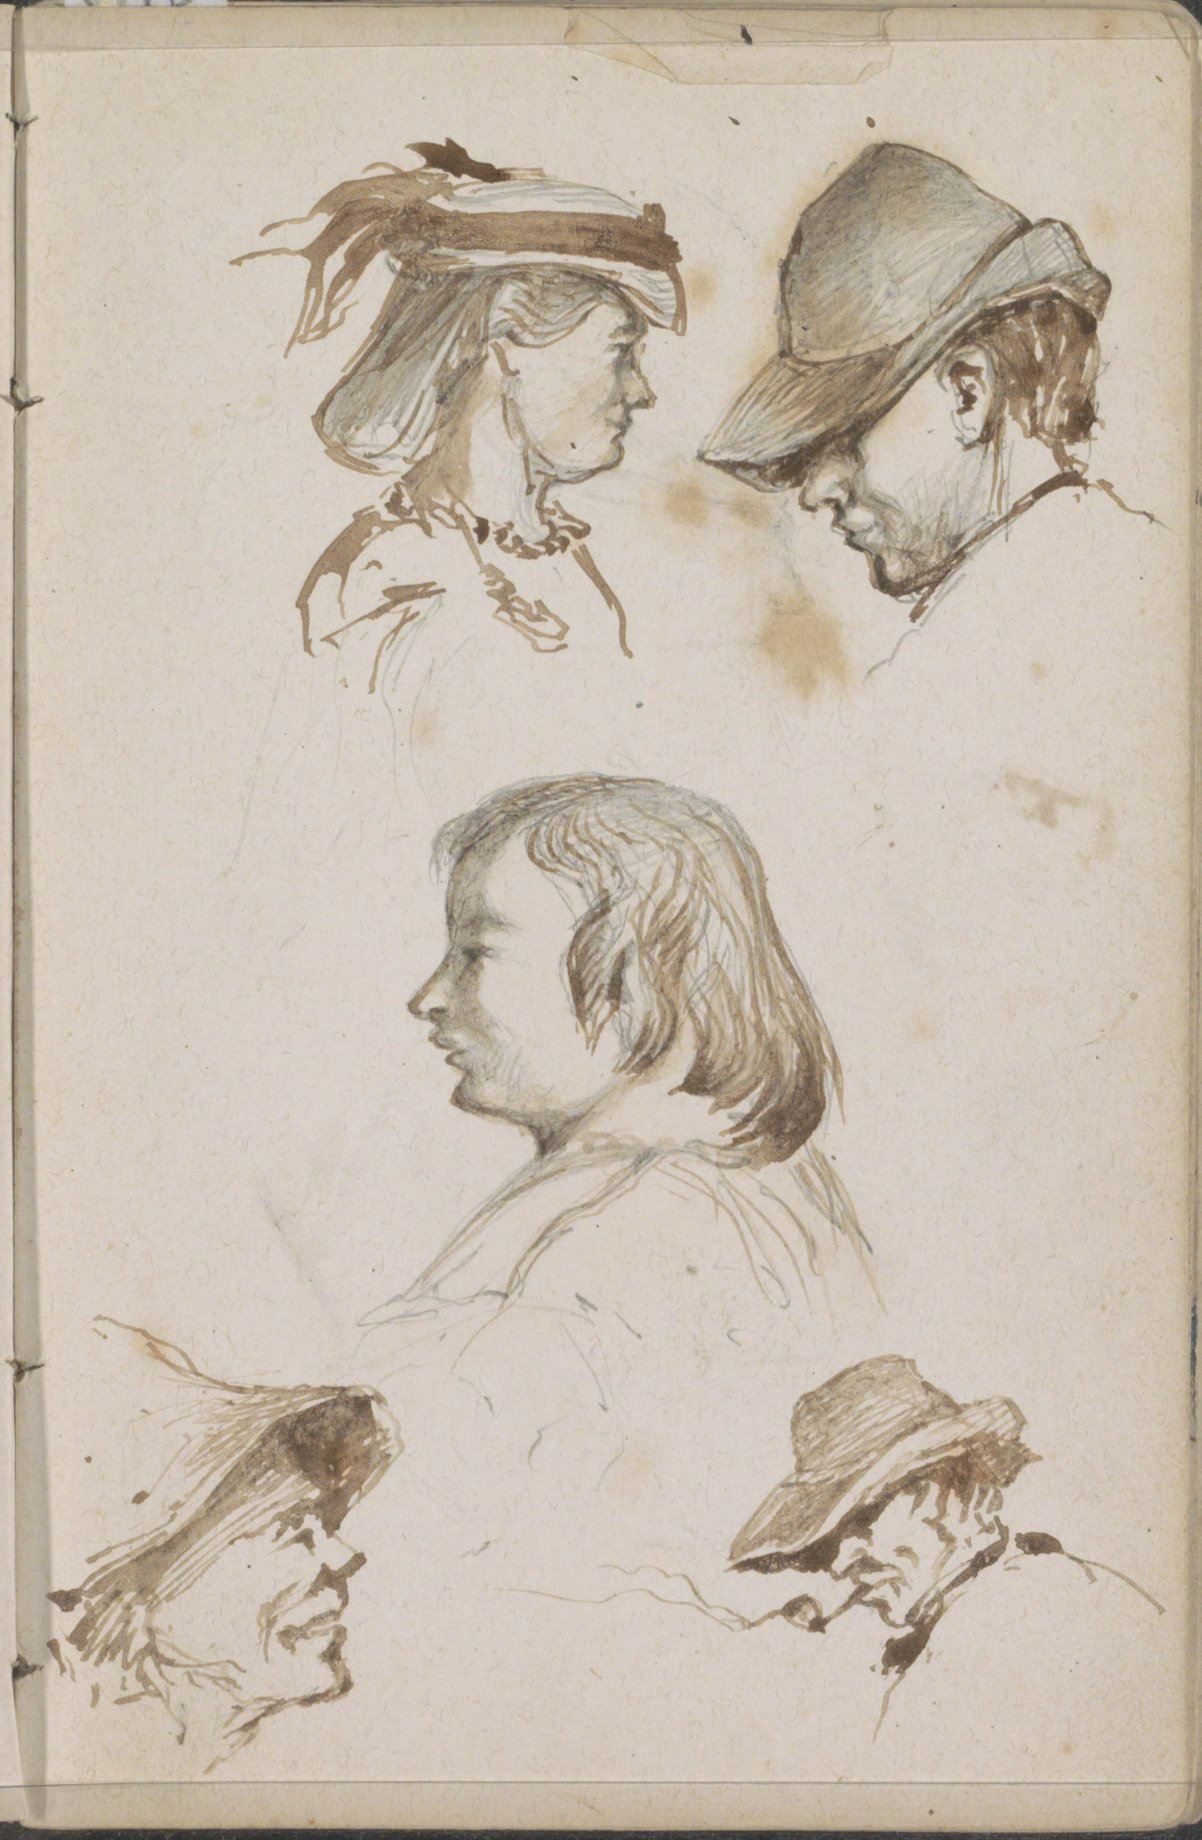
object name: sketchbook leaf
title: Mannenkoppen en een vrouwenkop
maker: johannes tavenraat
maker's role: draughtsman, painter, print maker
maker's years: 1809-1881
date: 1811-1862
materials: ink, paper, pencil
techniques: pen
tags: head (human), adult man, head-gear: hat (+ men's clothes)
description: Blad 36 recto uit een schetsboek met 65 bladen.